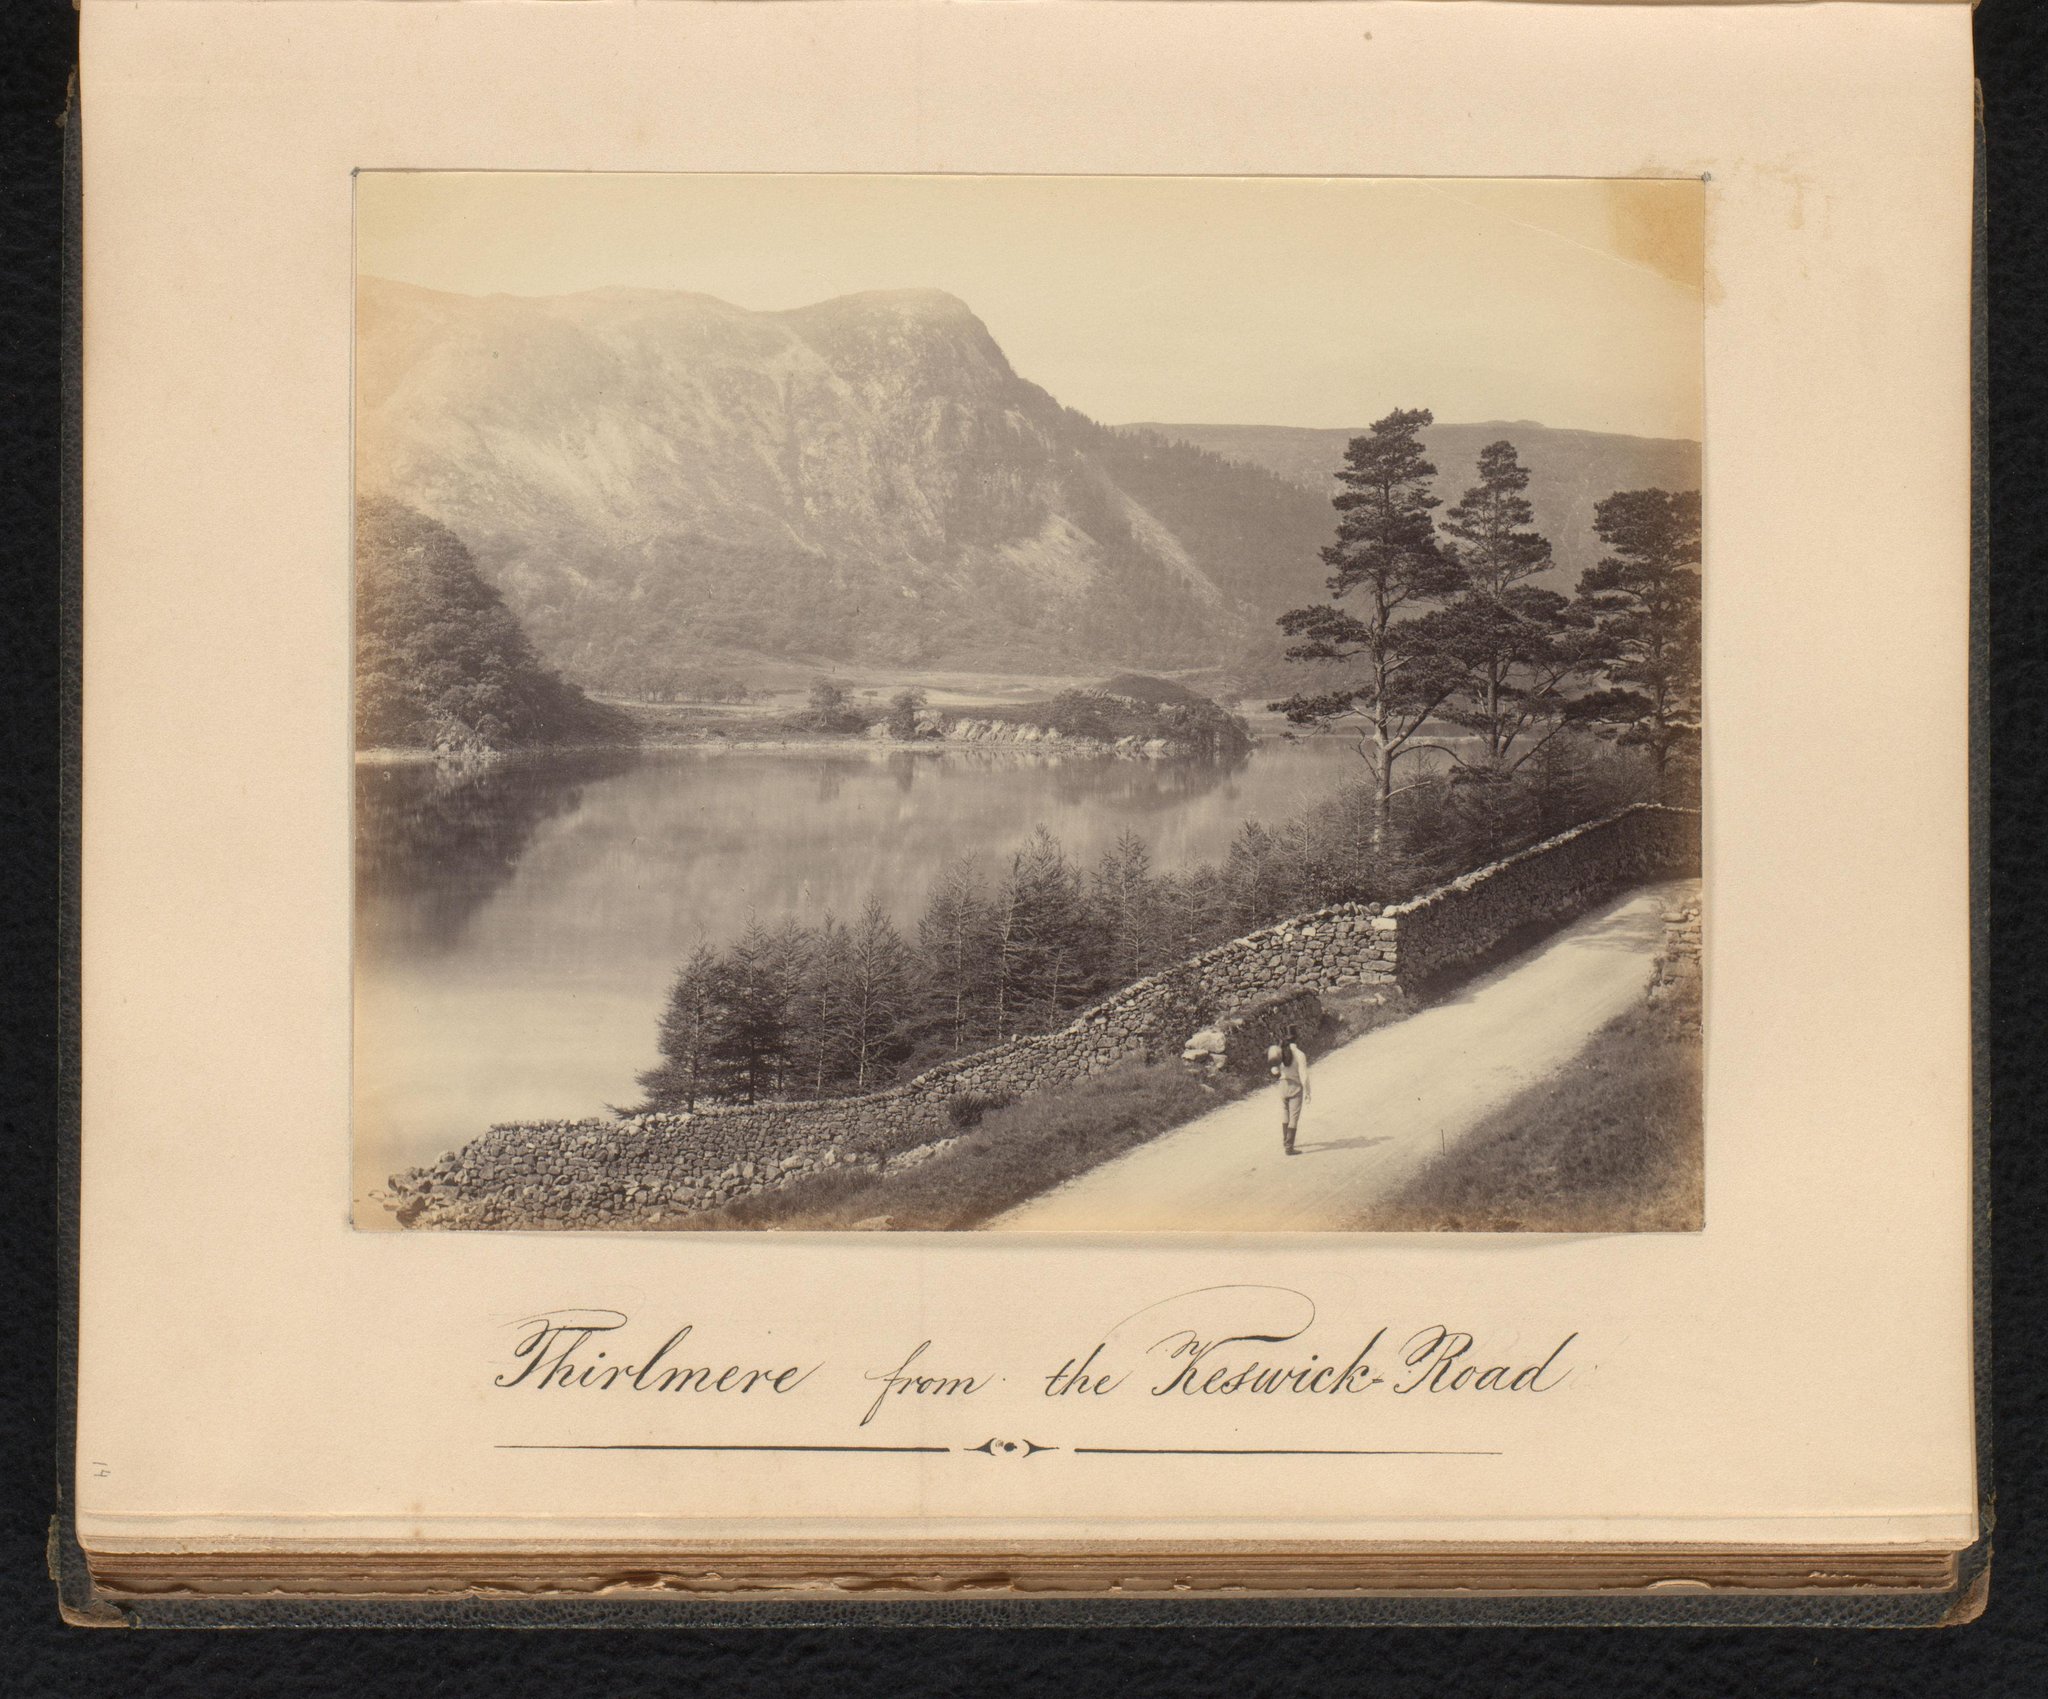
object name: album leaf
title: Thirlmere from the Keswick Road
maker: Anonymous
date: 1860-1870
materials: paper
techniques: albumen print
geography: thirlmere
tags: lake